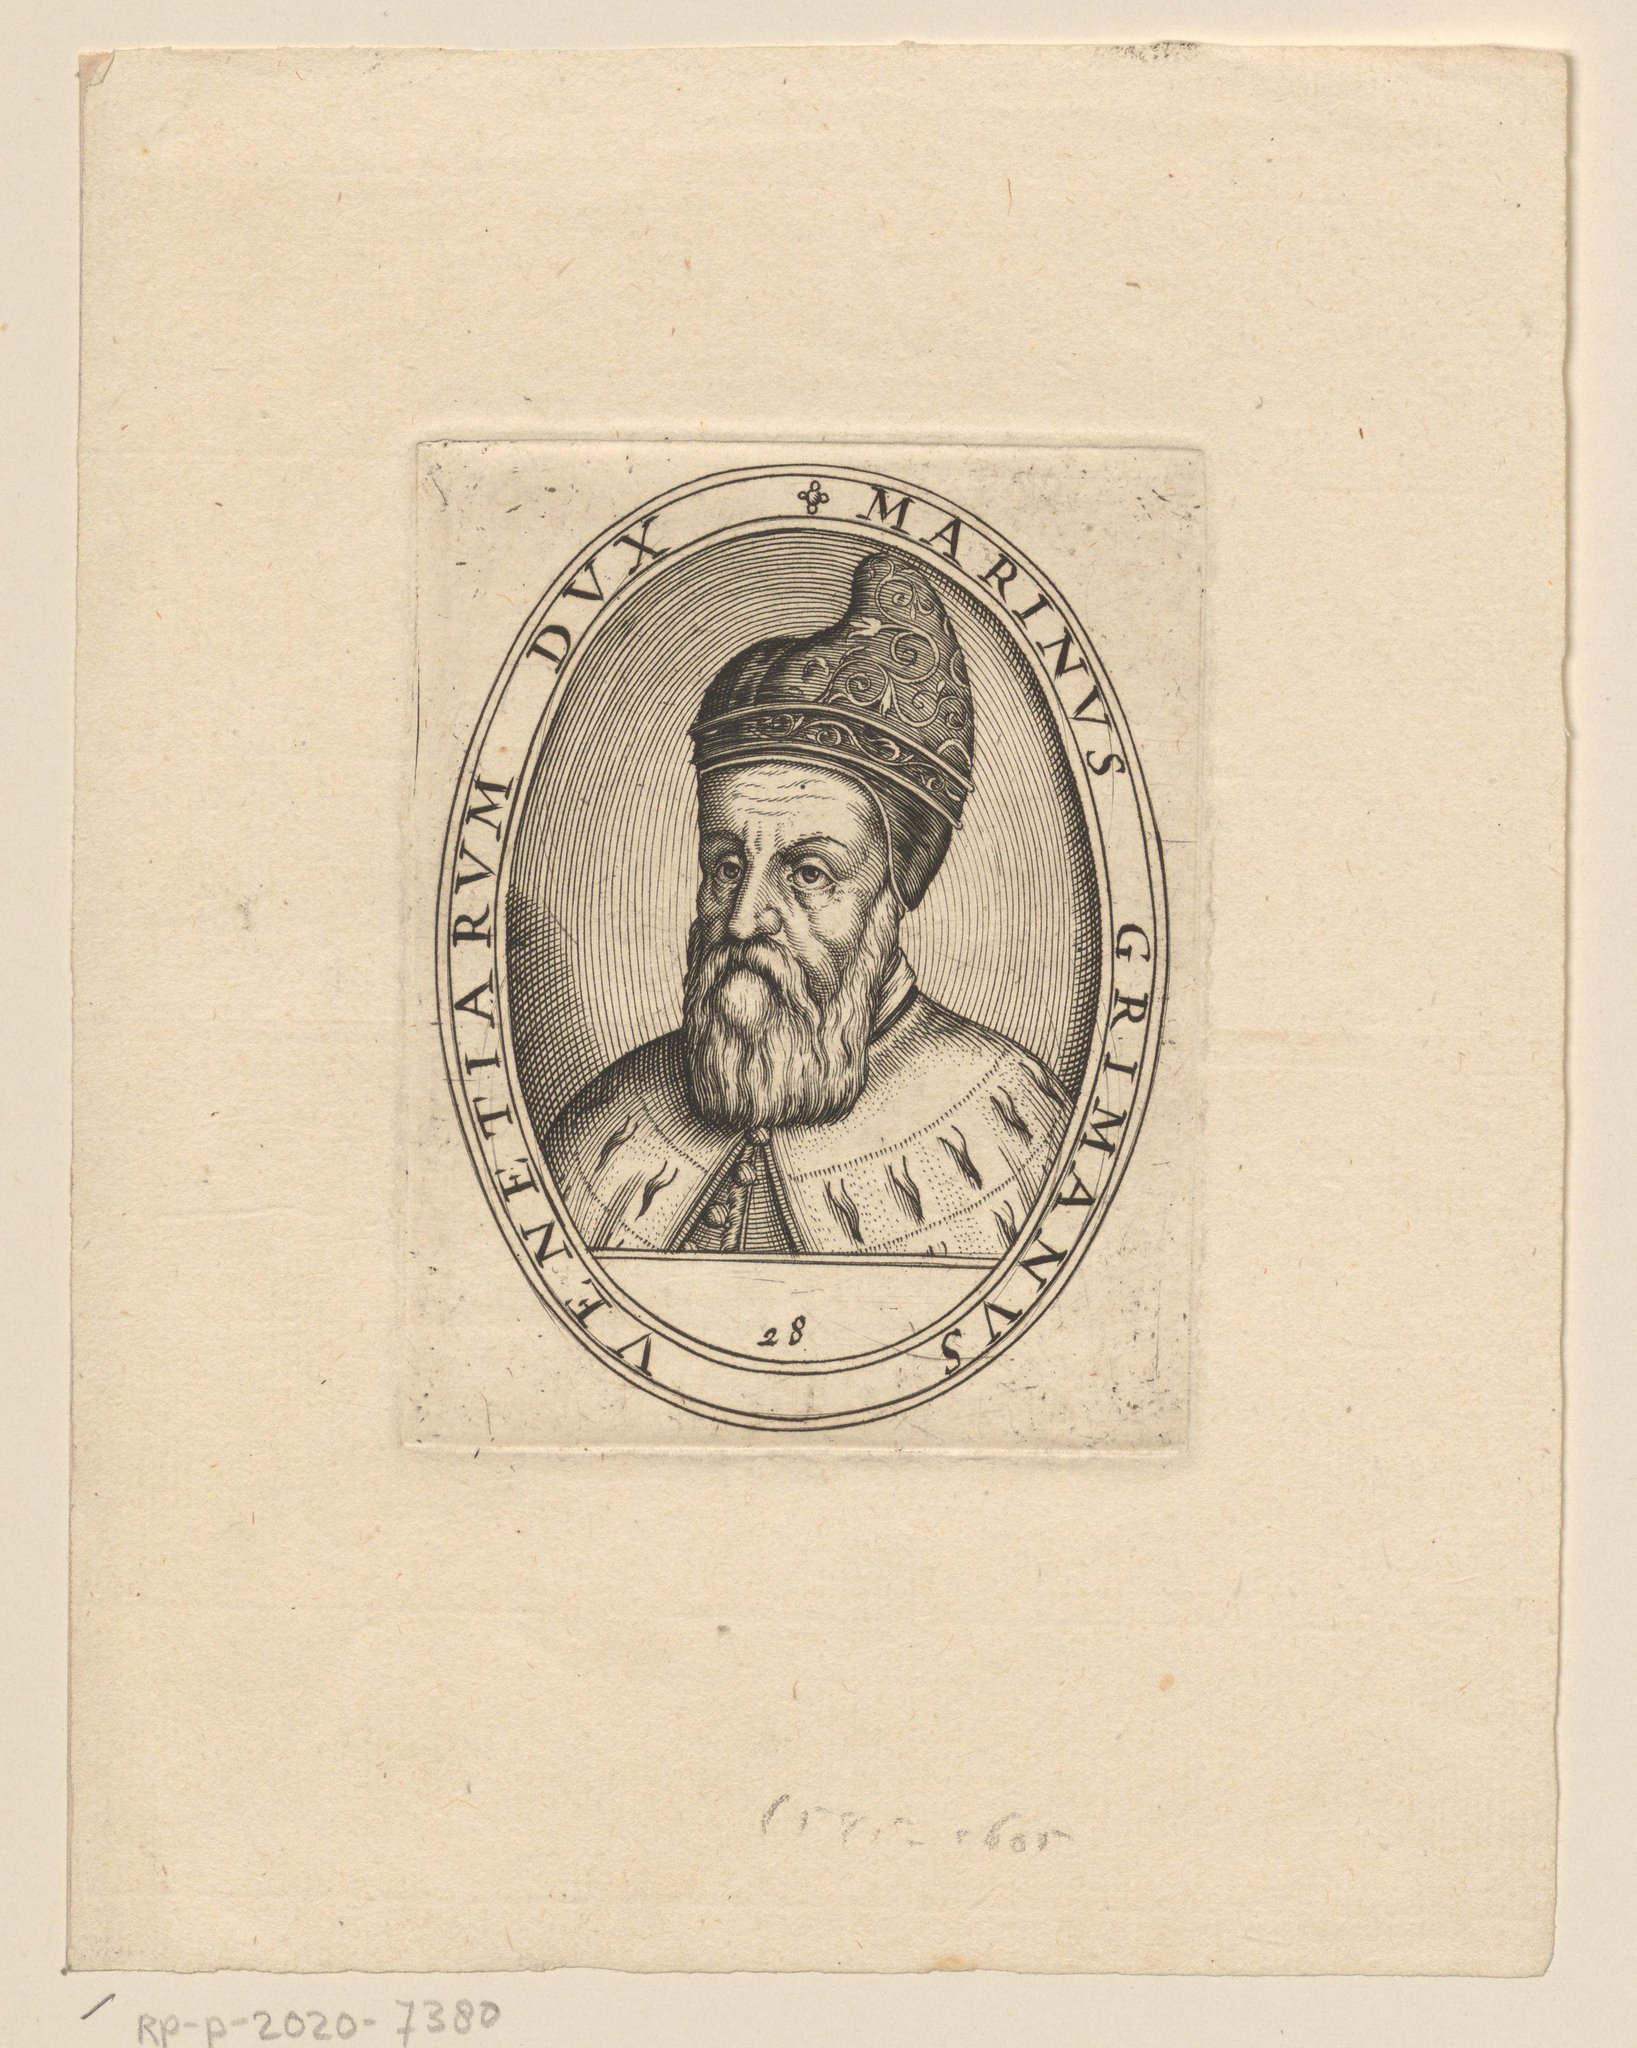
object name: print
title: Portret van Marino Grimani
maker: Anonymous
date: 1600-1700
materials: paper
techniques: engraving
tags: venice, historical persons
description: Tekst in het Latijn in de omlijsting. Genummerd: 28.